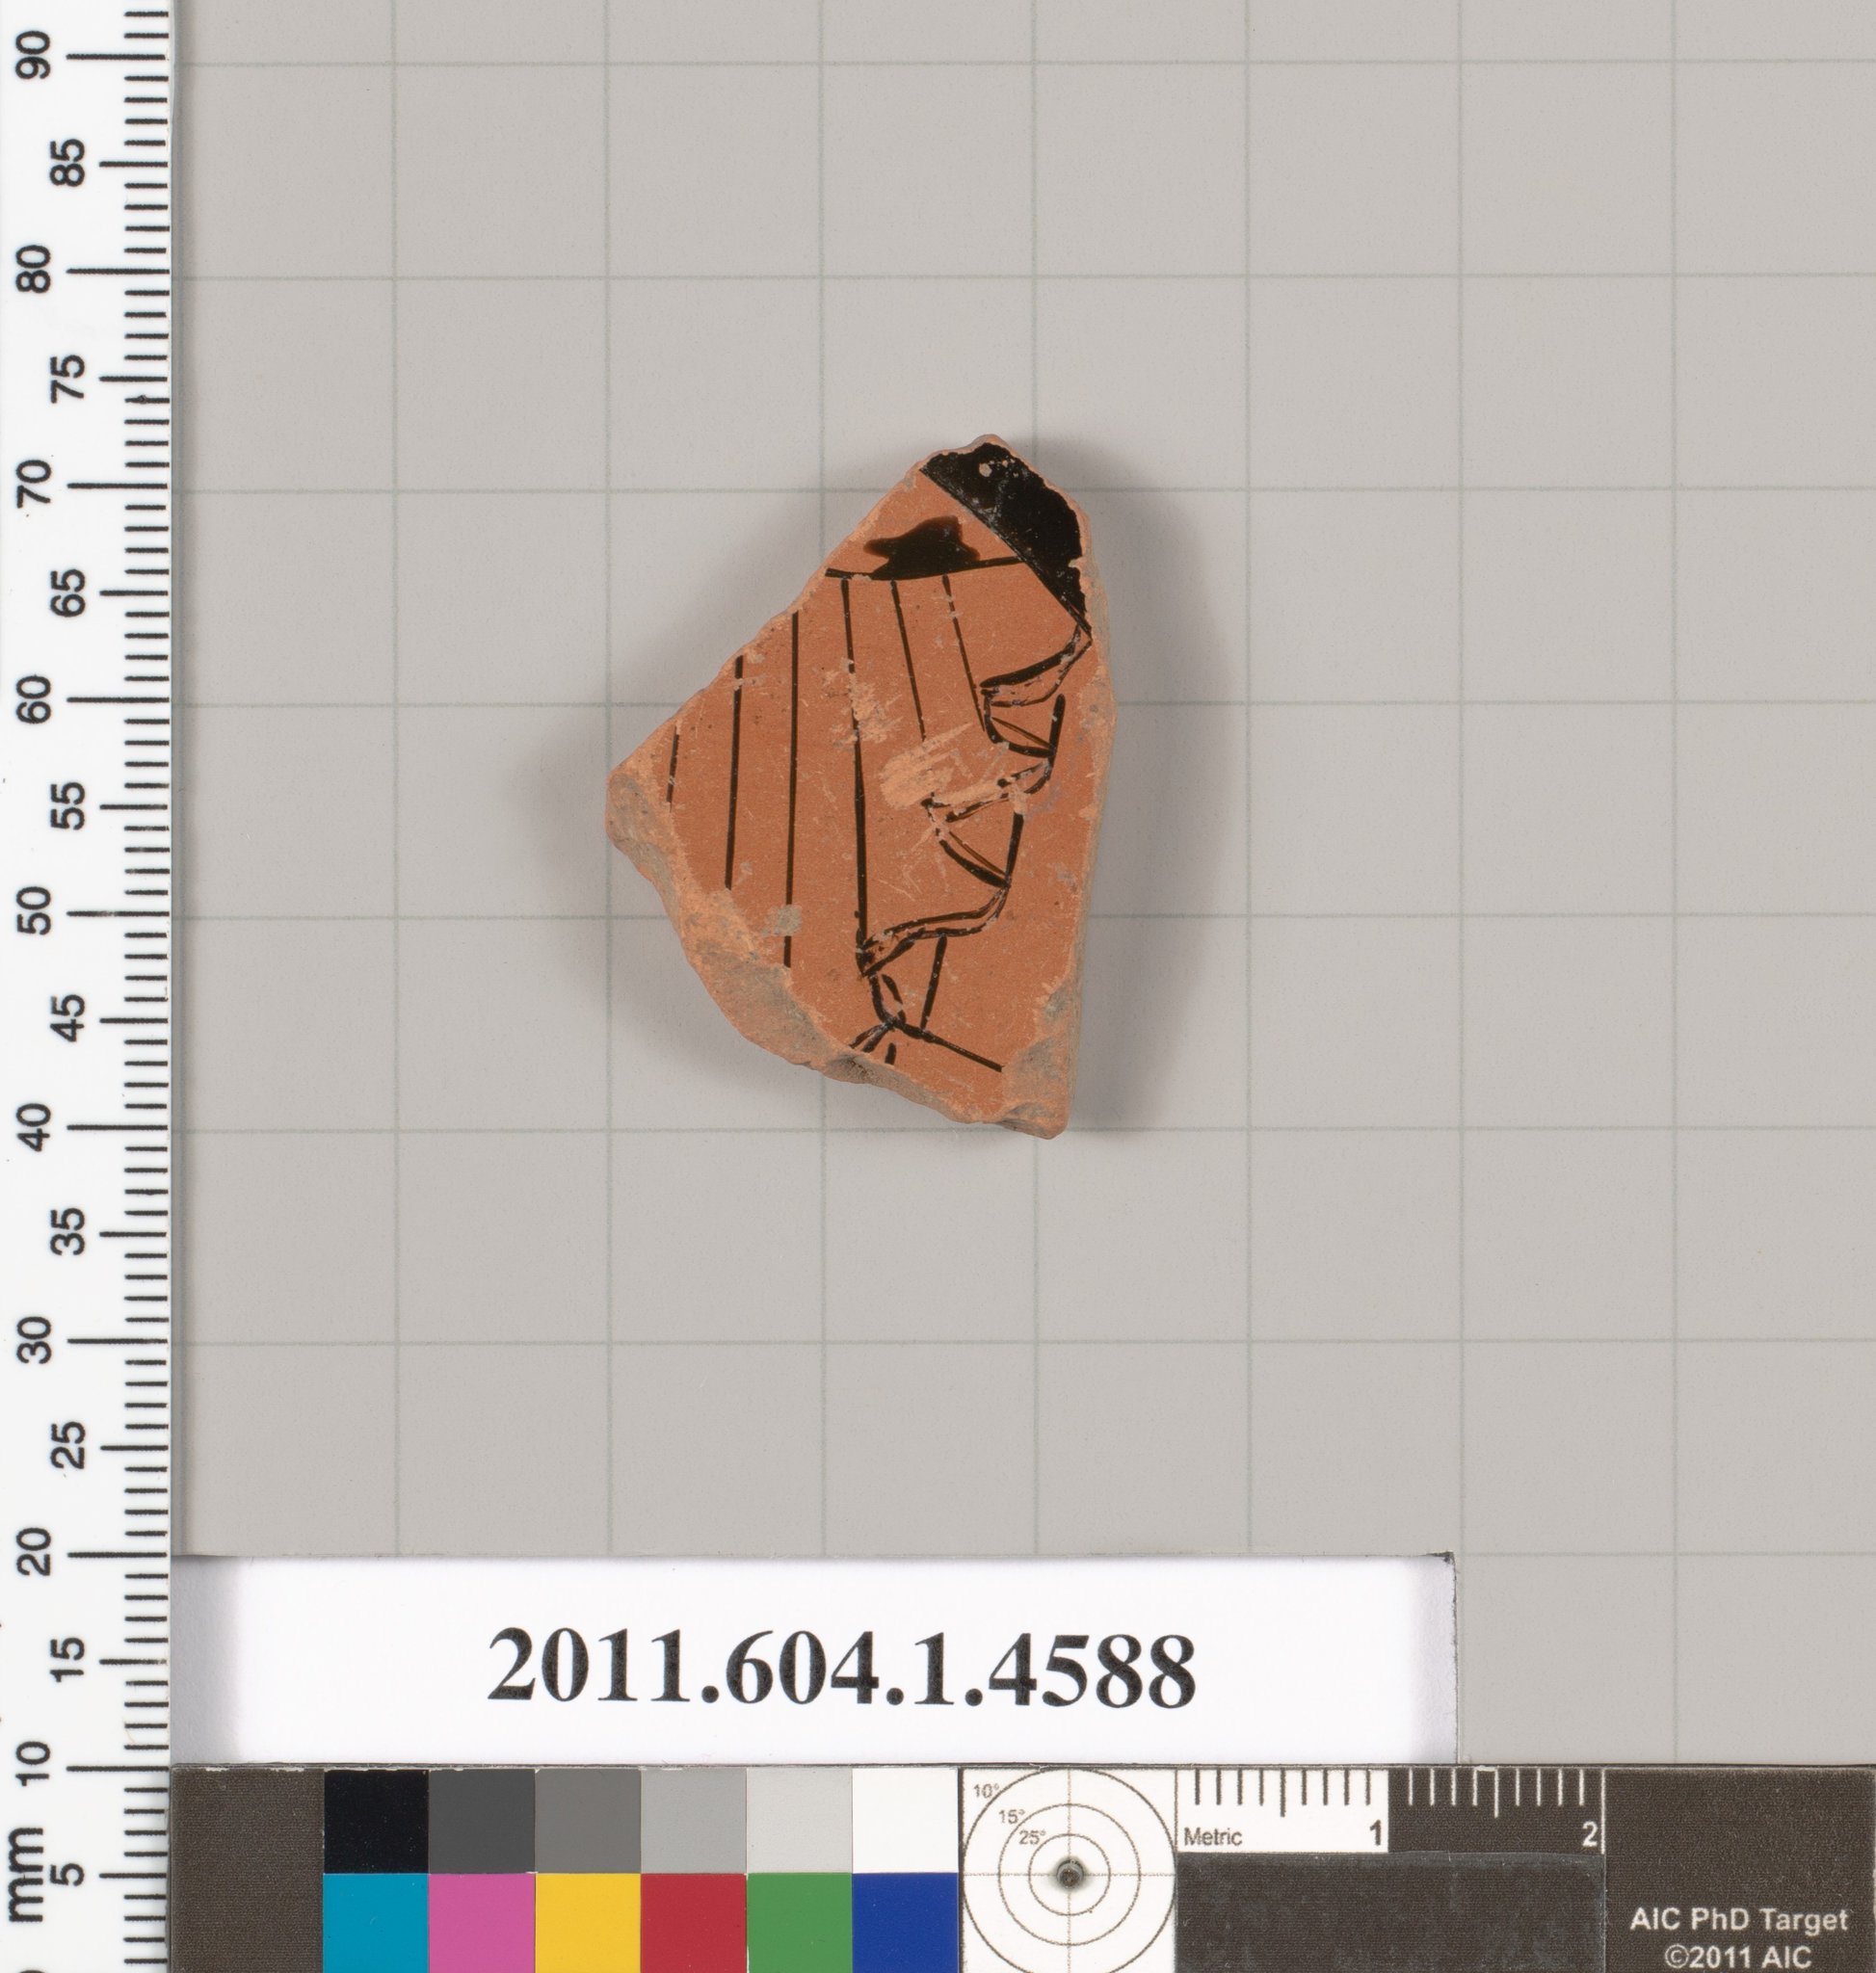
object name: kylix fragment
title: Terracotta fragment of a kylix (drinking cup)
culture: greek, attic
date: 500-480 BCE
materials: terracotta